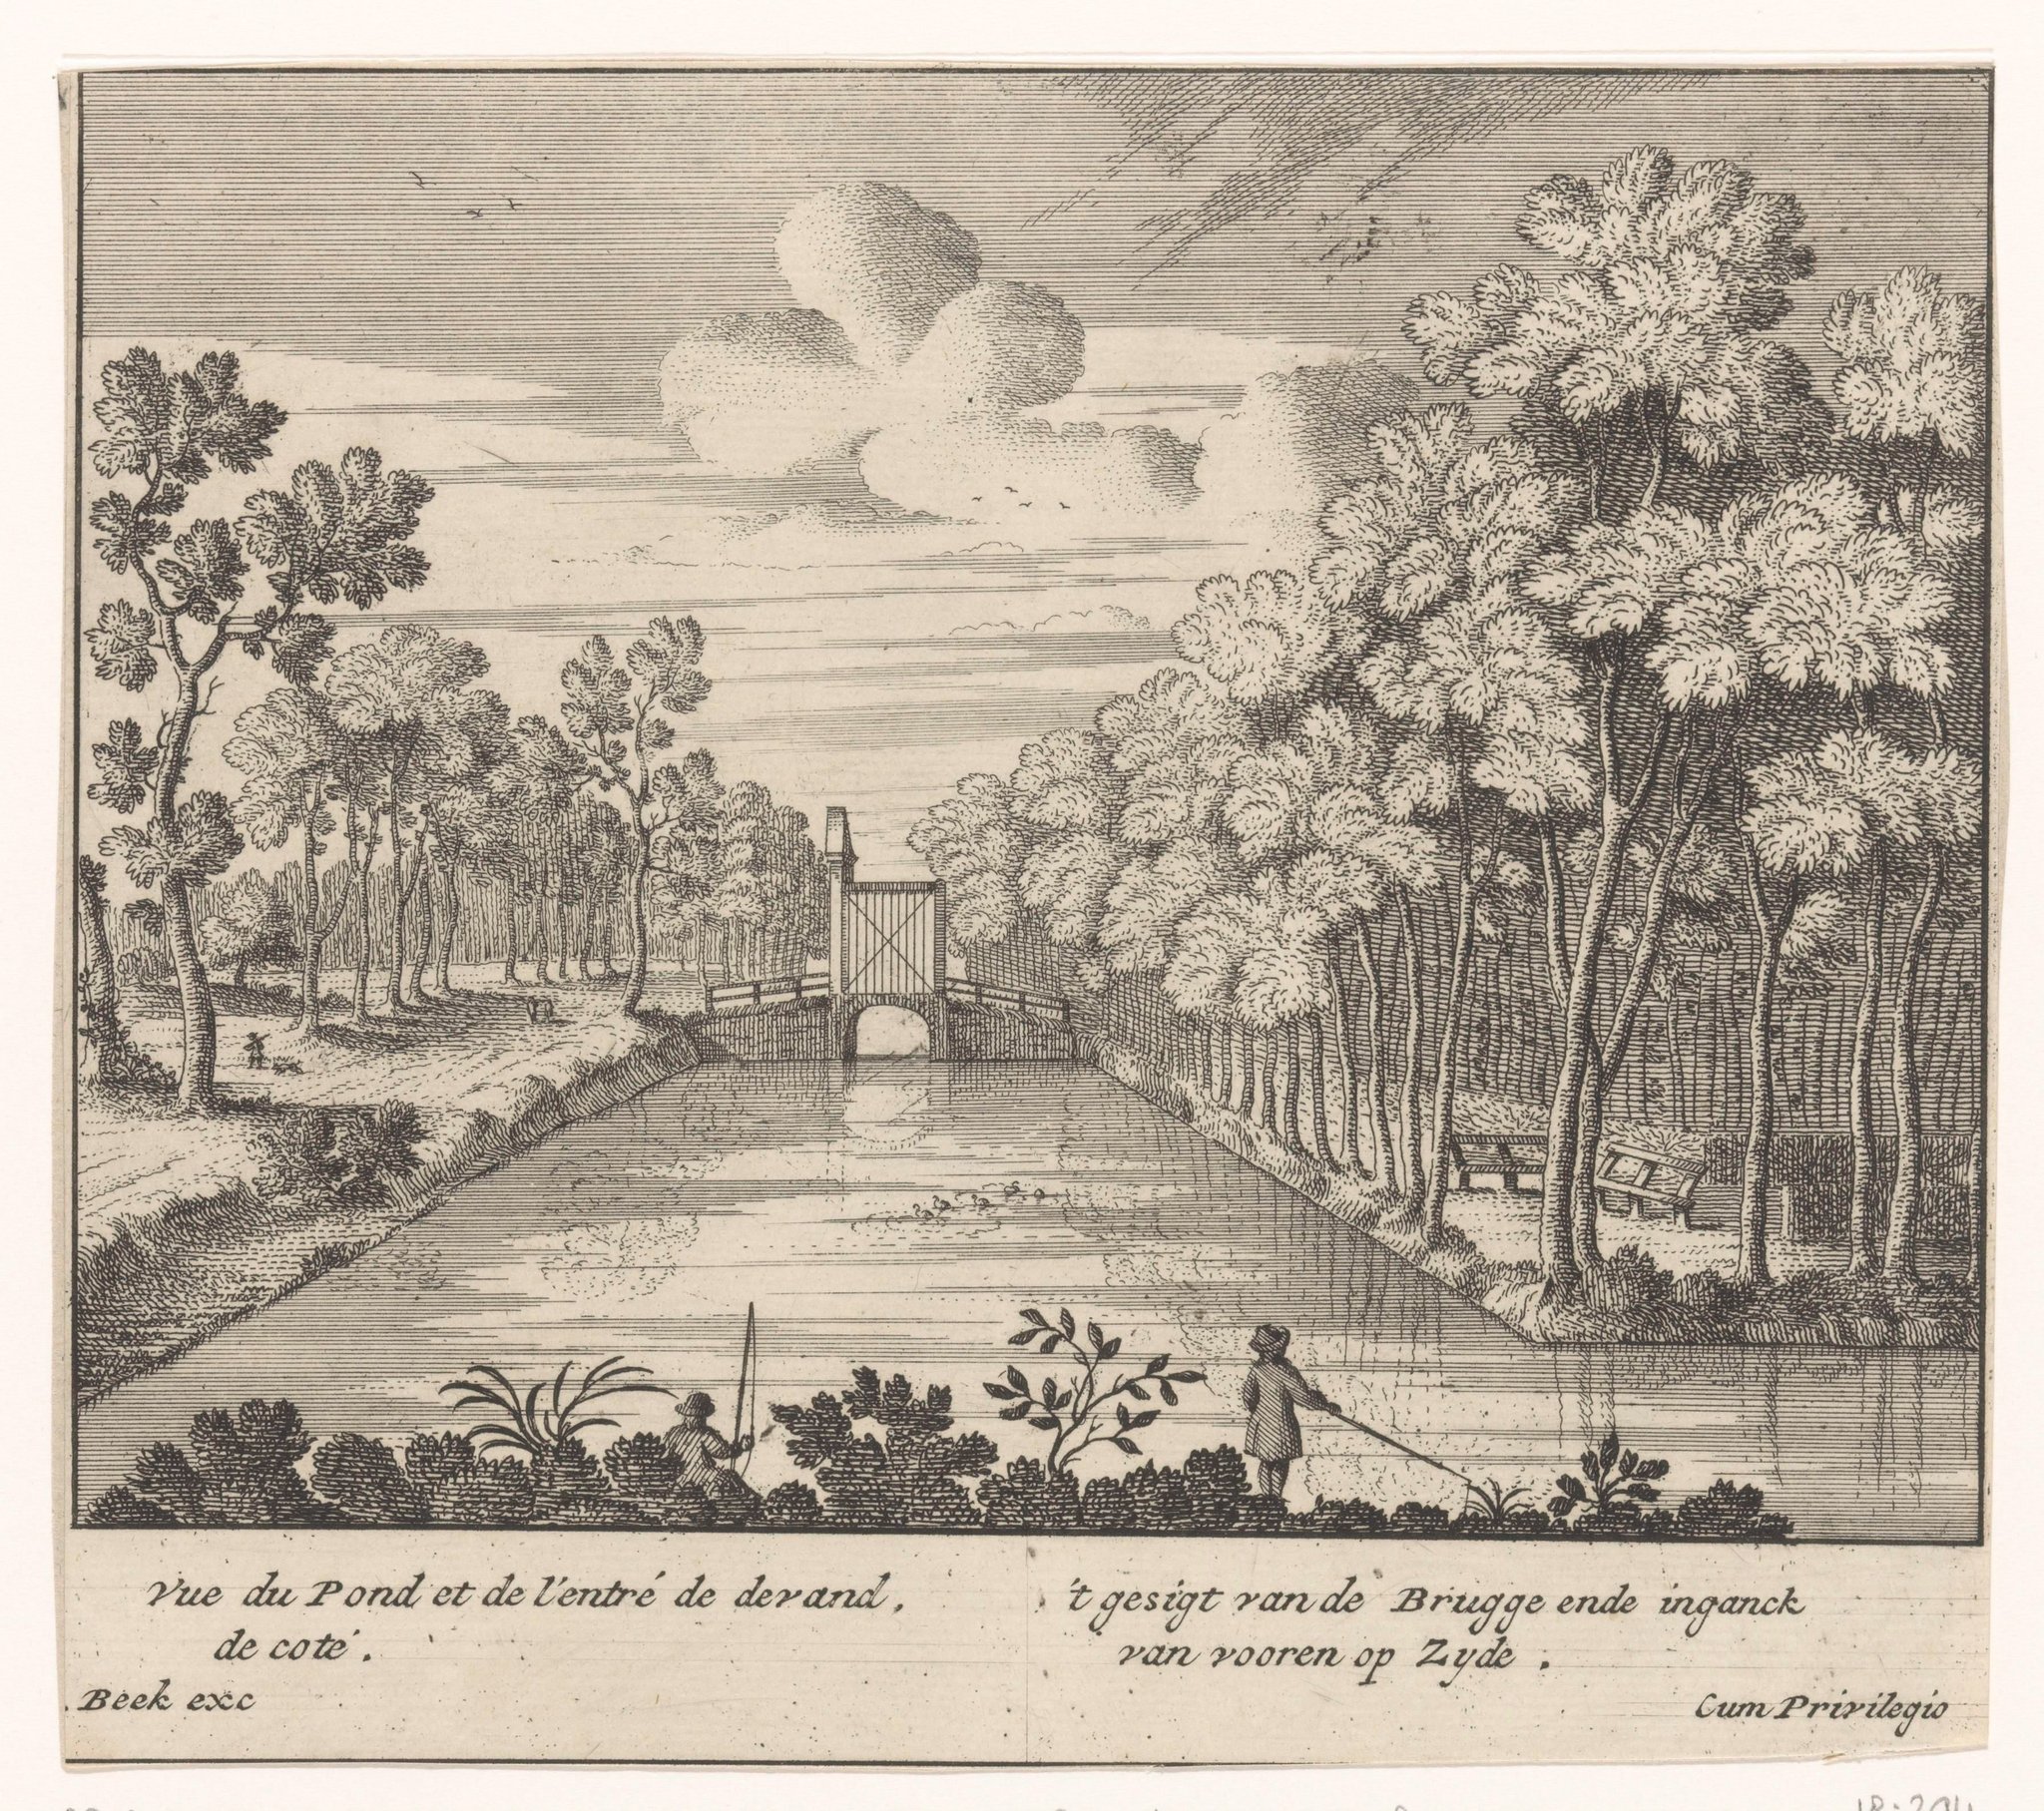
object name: print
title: Gezicht op de brug en toegangspoort voor Huis ten Bosch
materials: paper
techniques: etching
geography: the hague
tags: canal, palace, gate, entrance, bridge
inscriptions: collector's mark: Lugt 2228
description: Mogelijk uitgegeven als onderdeel van een serie van zestien prenten en een panorama van Huis ten Bosch. Zie ook RP-P-AO-12-97-1, RP-P-AO-12-97-2, RP-P-AO-12-97-3, RP-P-AO-12-97-4, RP-P-AO-12-97-5, RP-P-AO-12-97-6, RP-P-AO-12-97-7, RP-P-AO-12-97-8, RP-P-AO-12-97-9, RP-P-AO-12-97-10, RP-P-AO-12-97-11, RP-P-AO-12-97-12, RP-P-AO-12-97-13 en RP-P-AO-12-97-15.